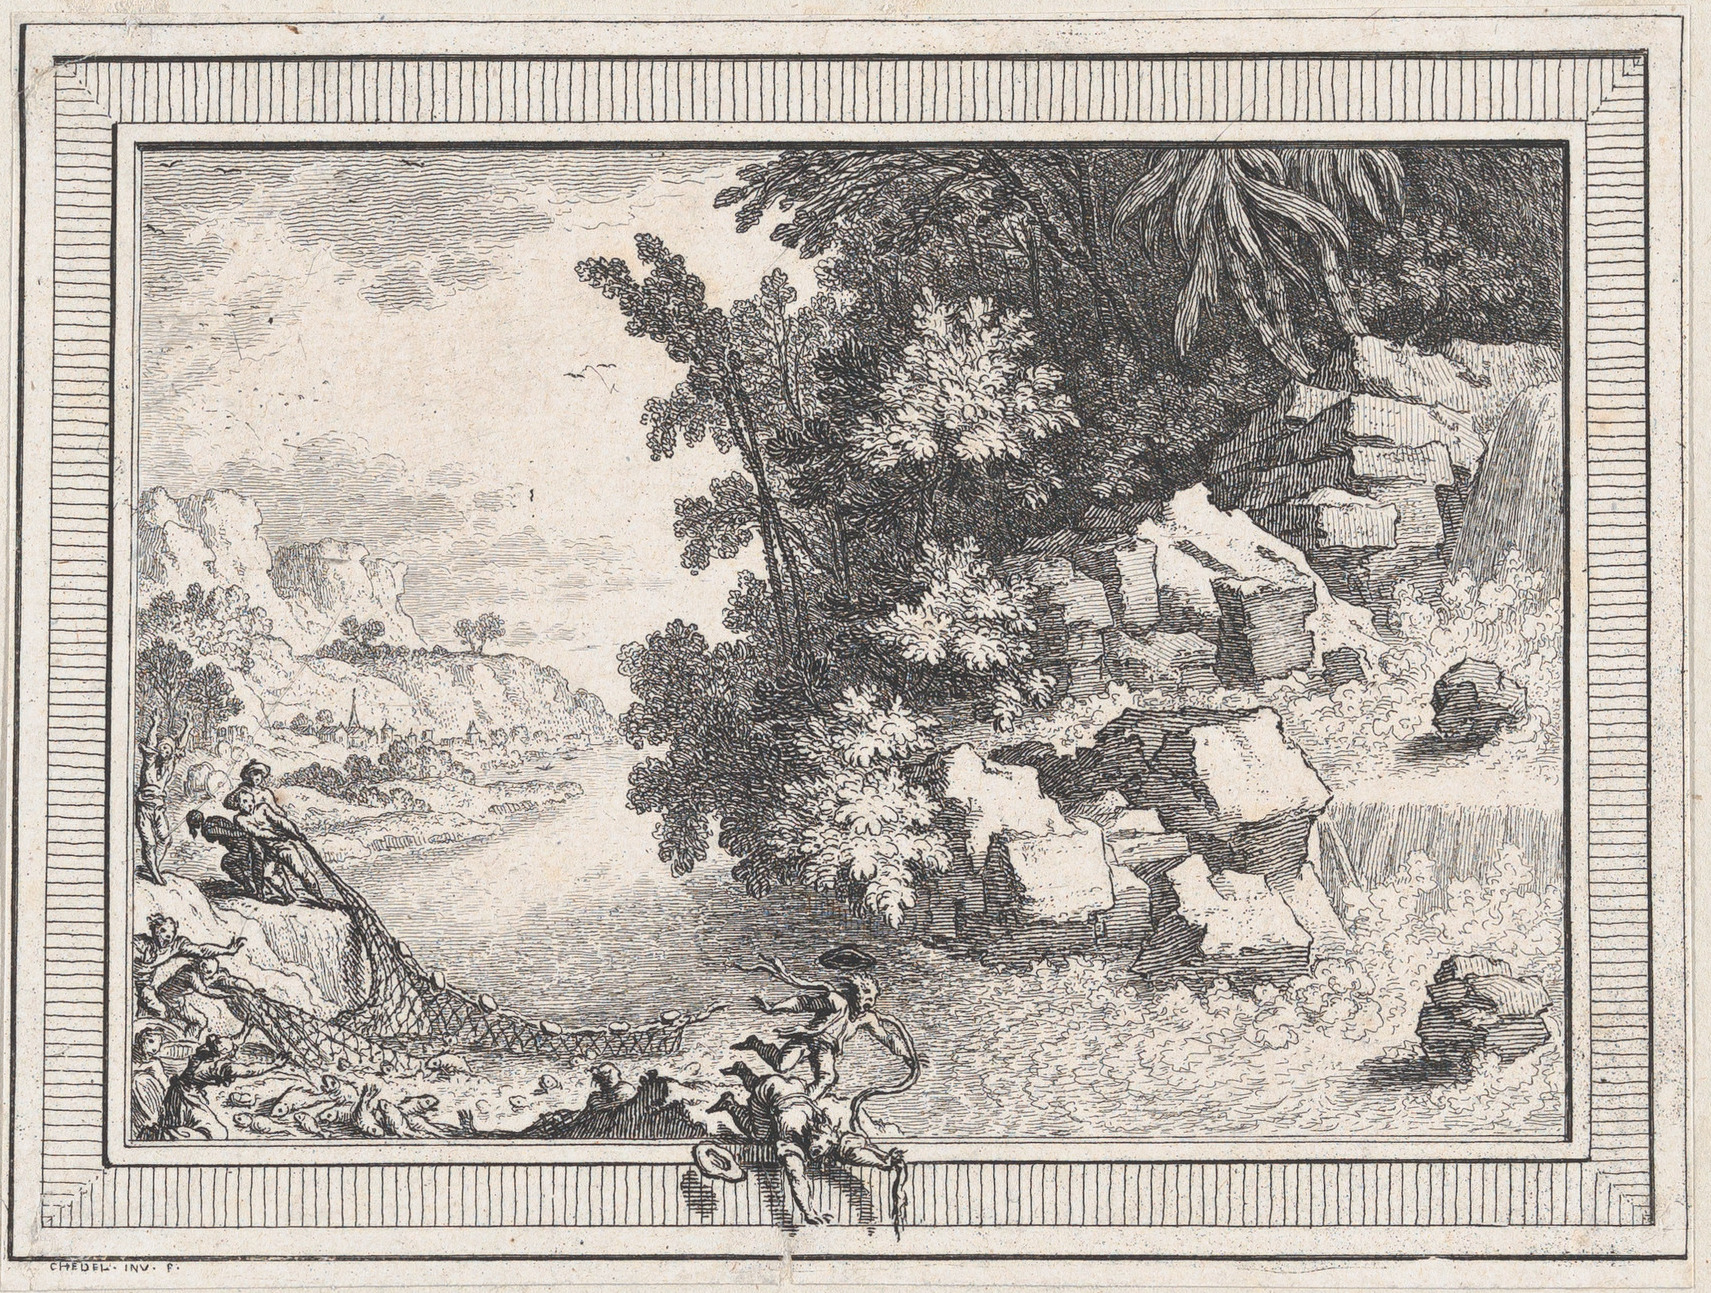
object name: print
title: Landscape, from a series of six landscapes dedicated to Madame La Marquise de Pompadour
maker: quentin pierre chedel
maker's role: artist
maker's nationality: french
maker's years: 1705-1763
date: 1701-1800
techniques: etching